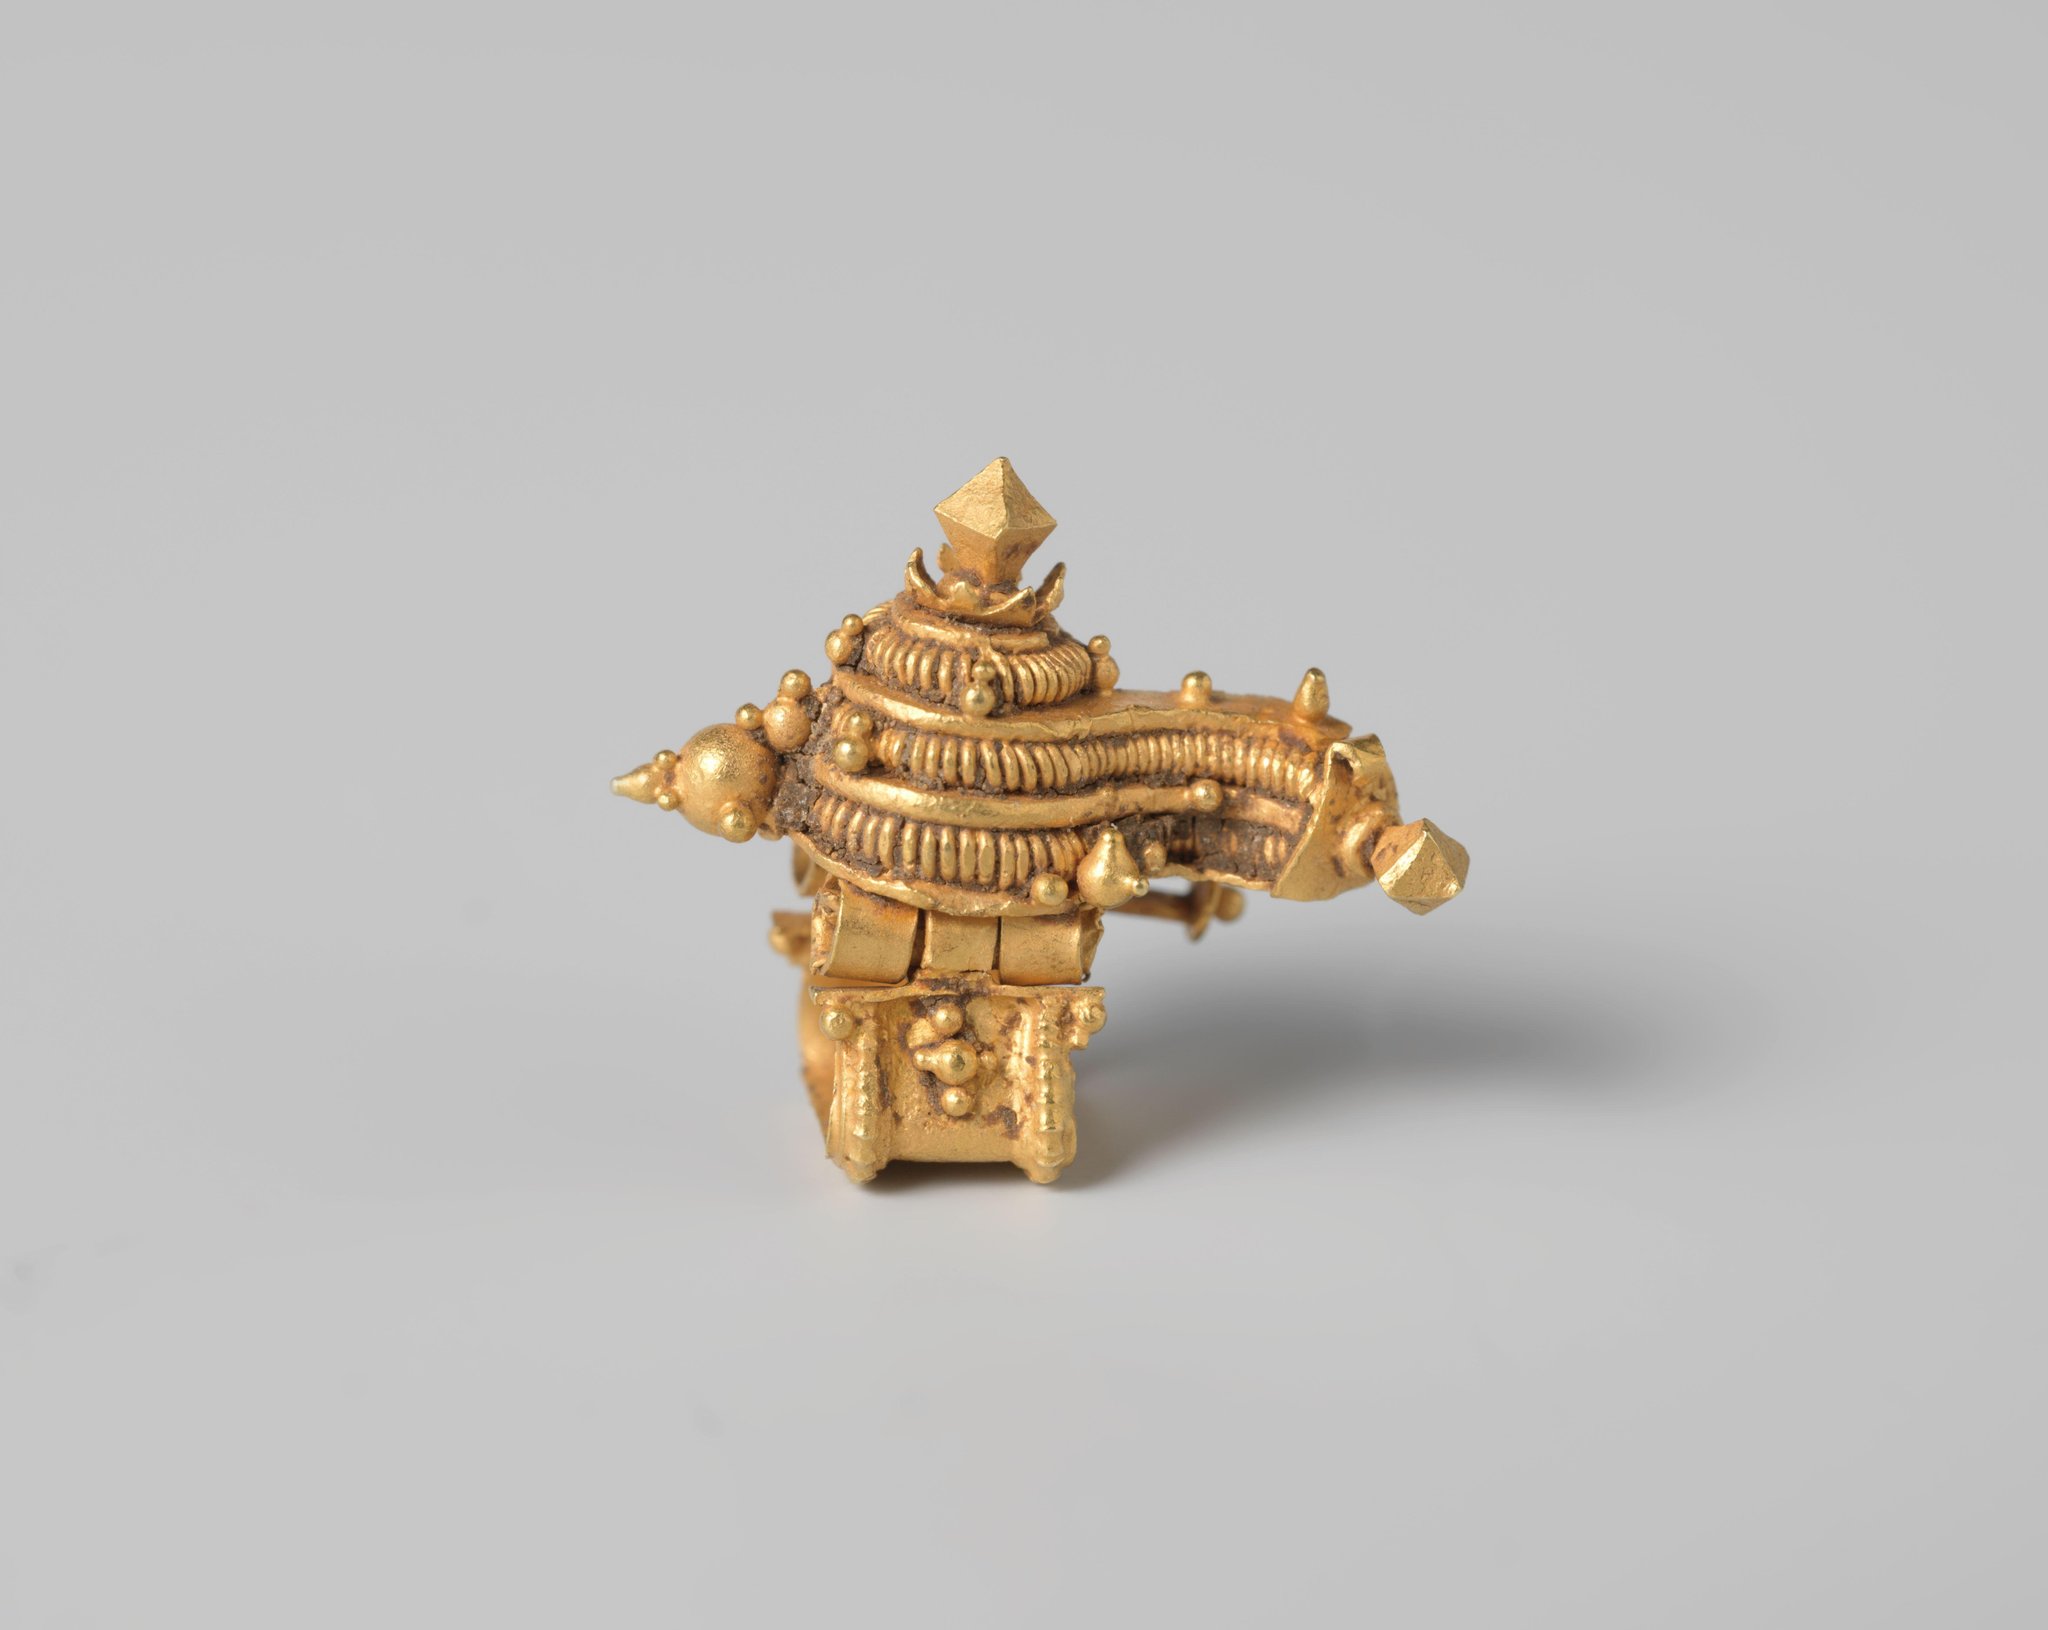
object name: jewellery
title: Sieraad in de vorm van een schelphoorn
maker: Anonymous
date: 1400-1500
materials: gold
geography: java